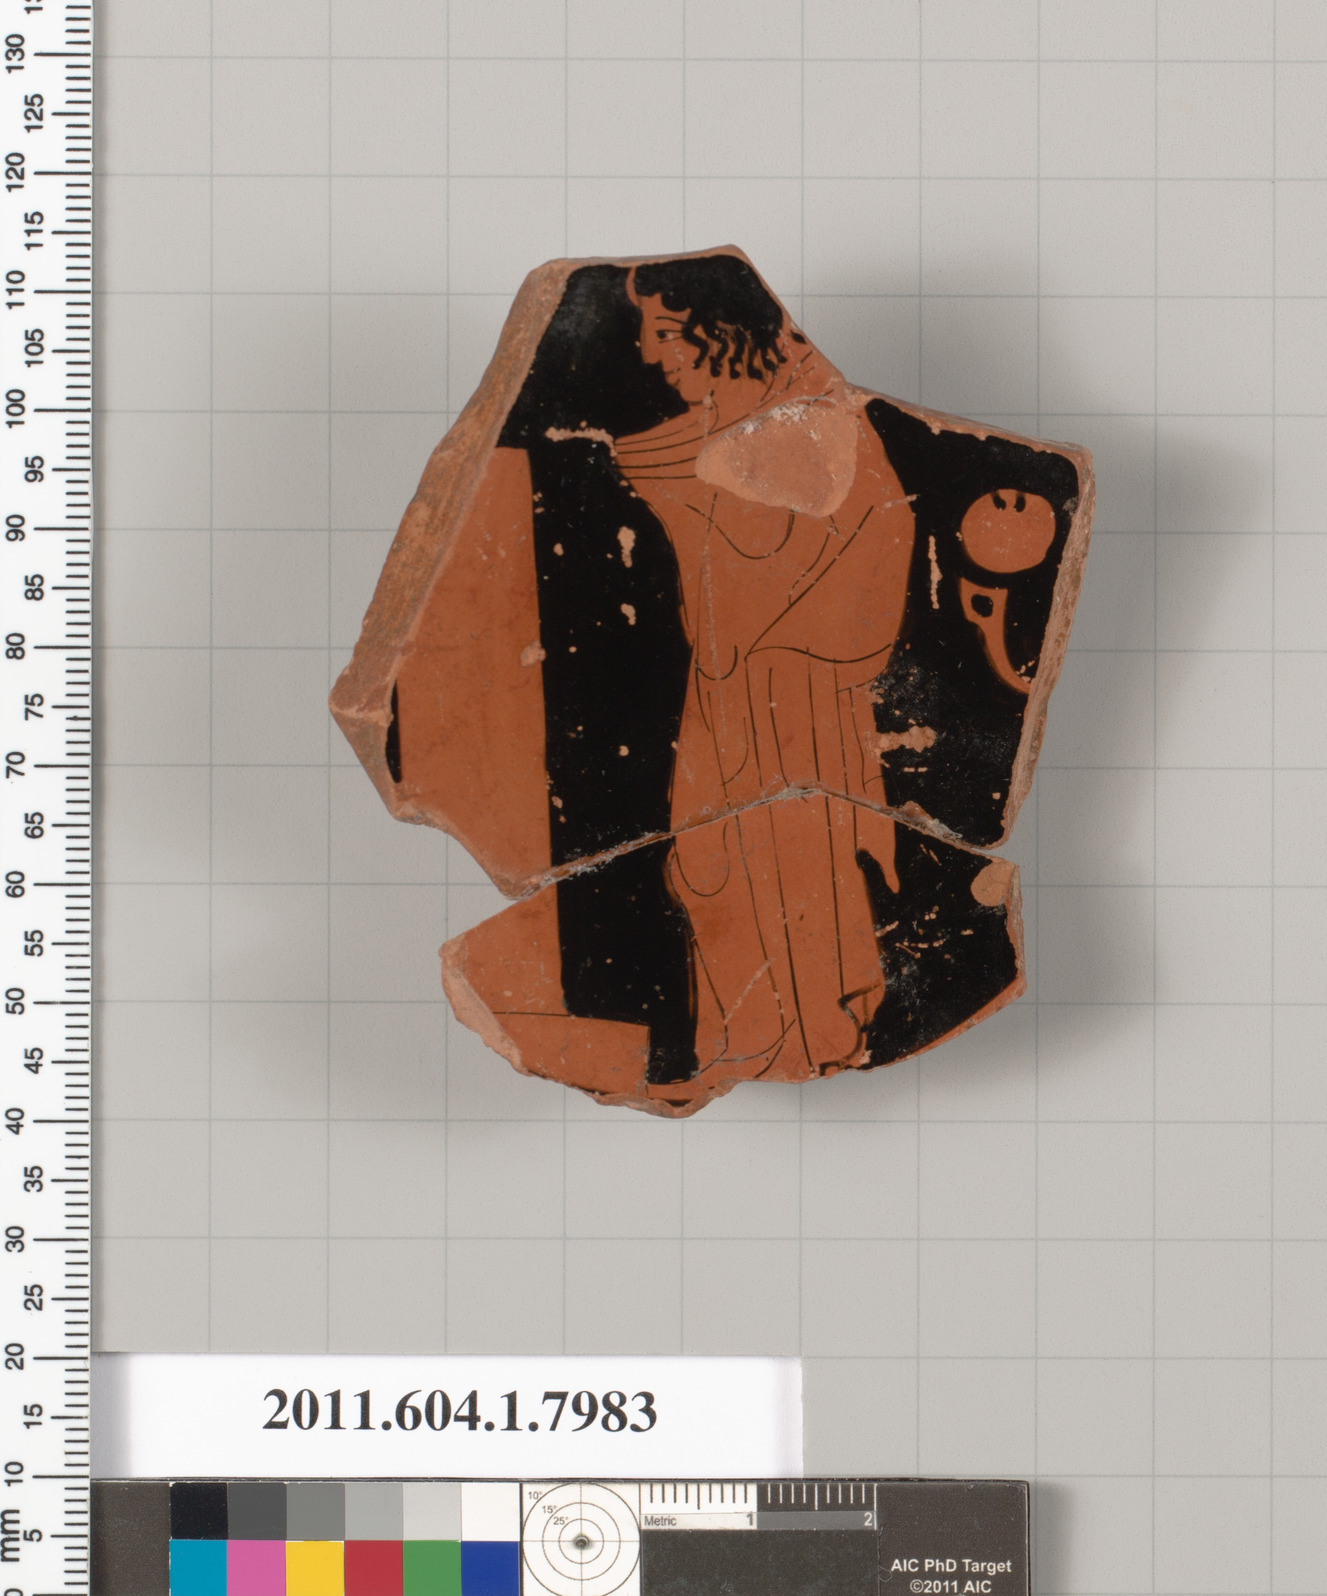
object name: kylix fragment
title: Terracotta fragment of a kylix (drinking cup)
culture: greek, attic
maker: curtius painter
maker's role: artist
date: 460-450 BCE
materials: terracotta